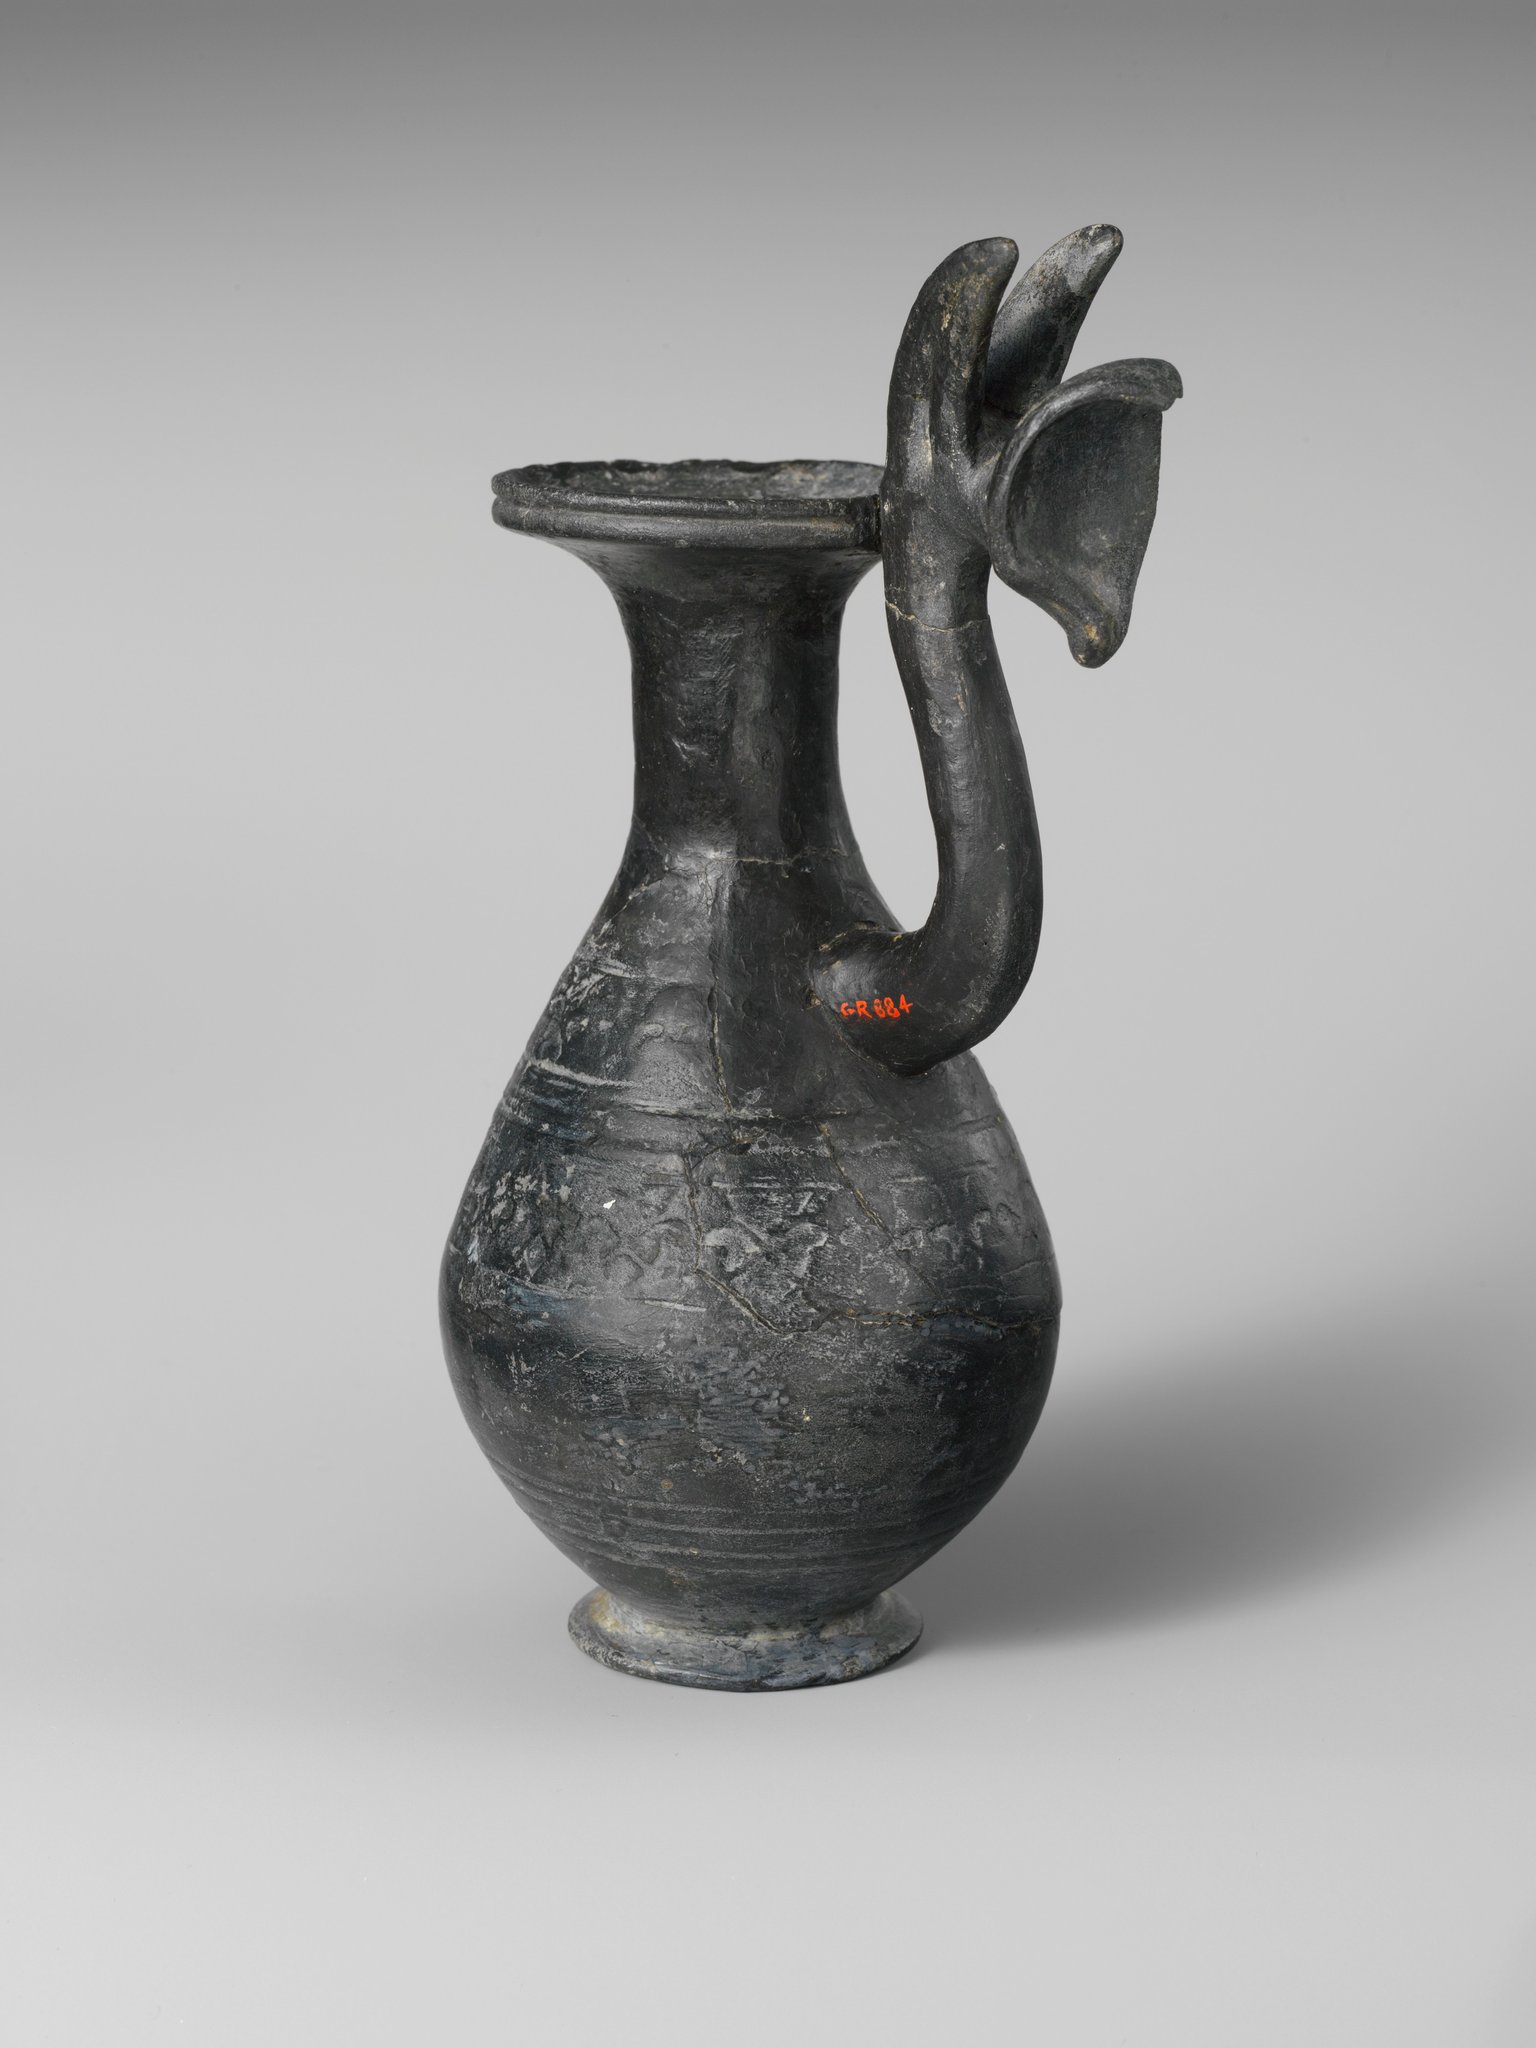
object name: oinochoe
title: Terracotta jug with griffin protome handle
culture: etruscan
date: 600-551 BCE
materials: terracotta